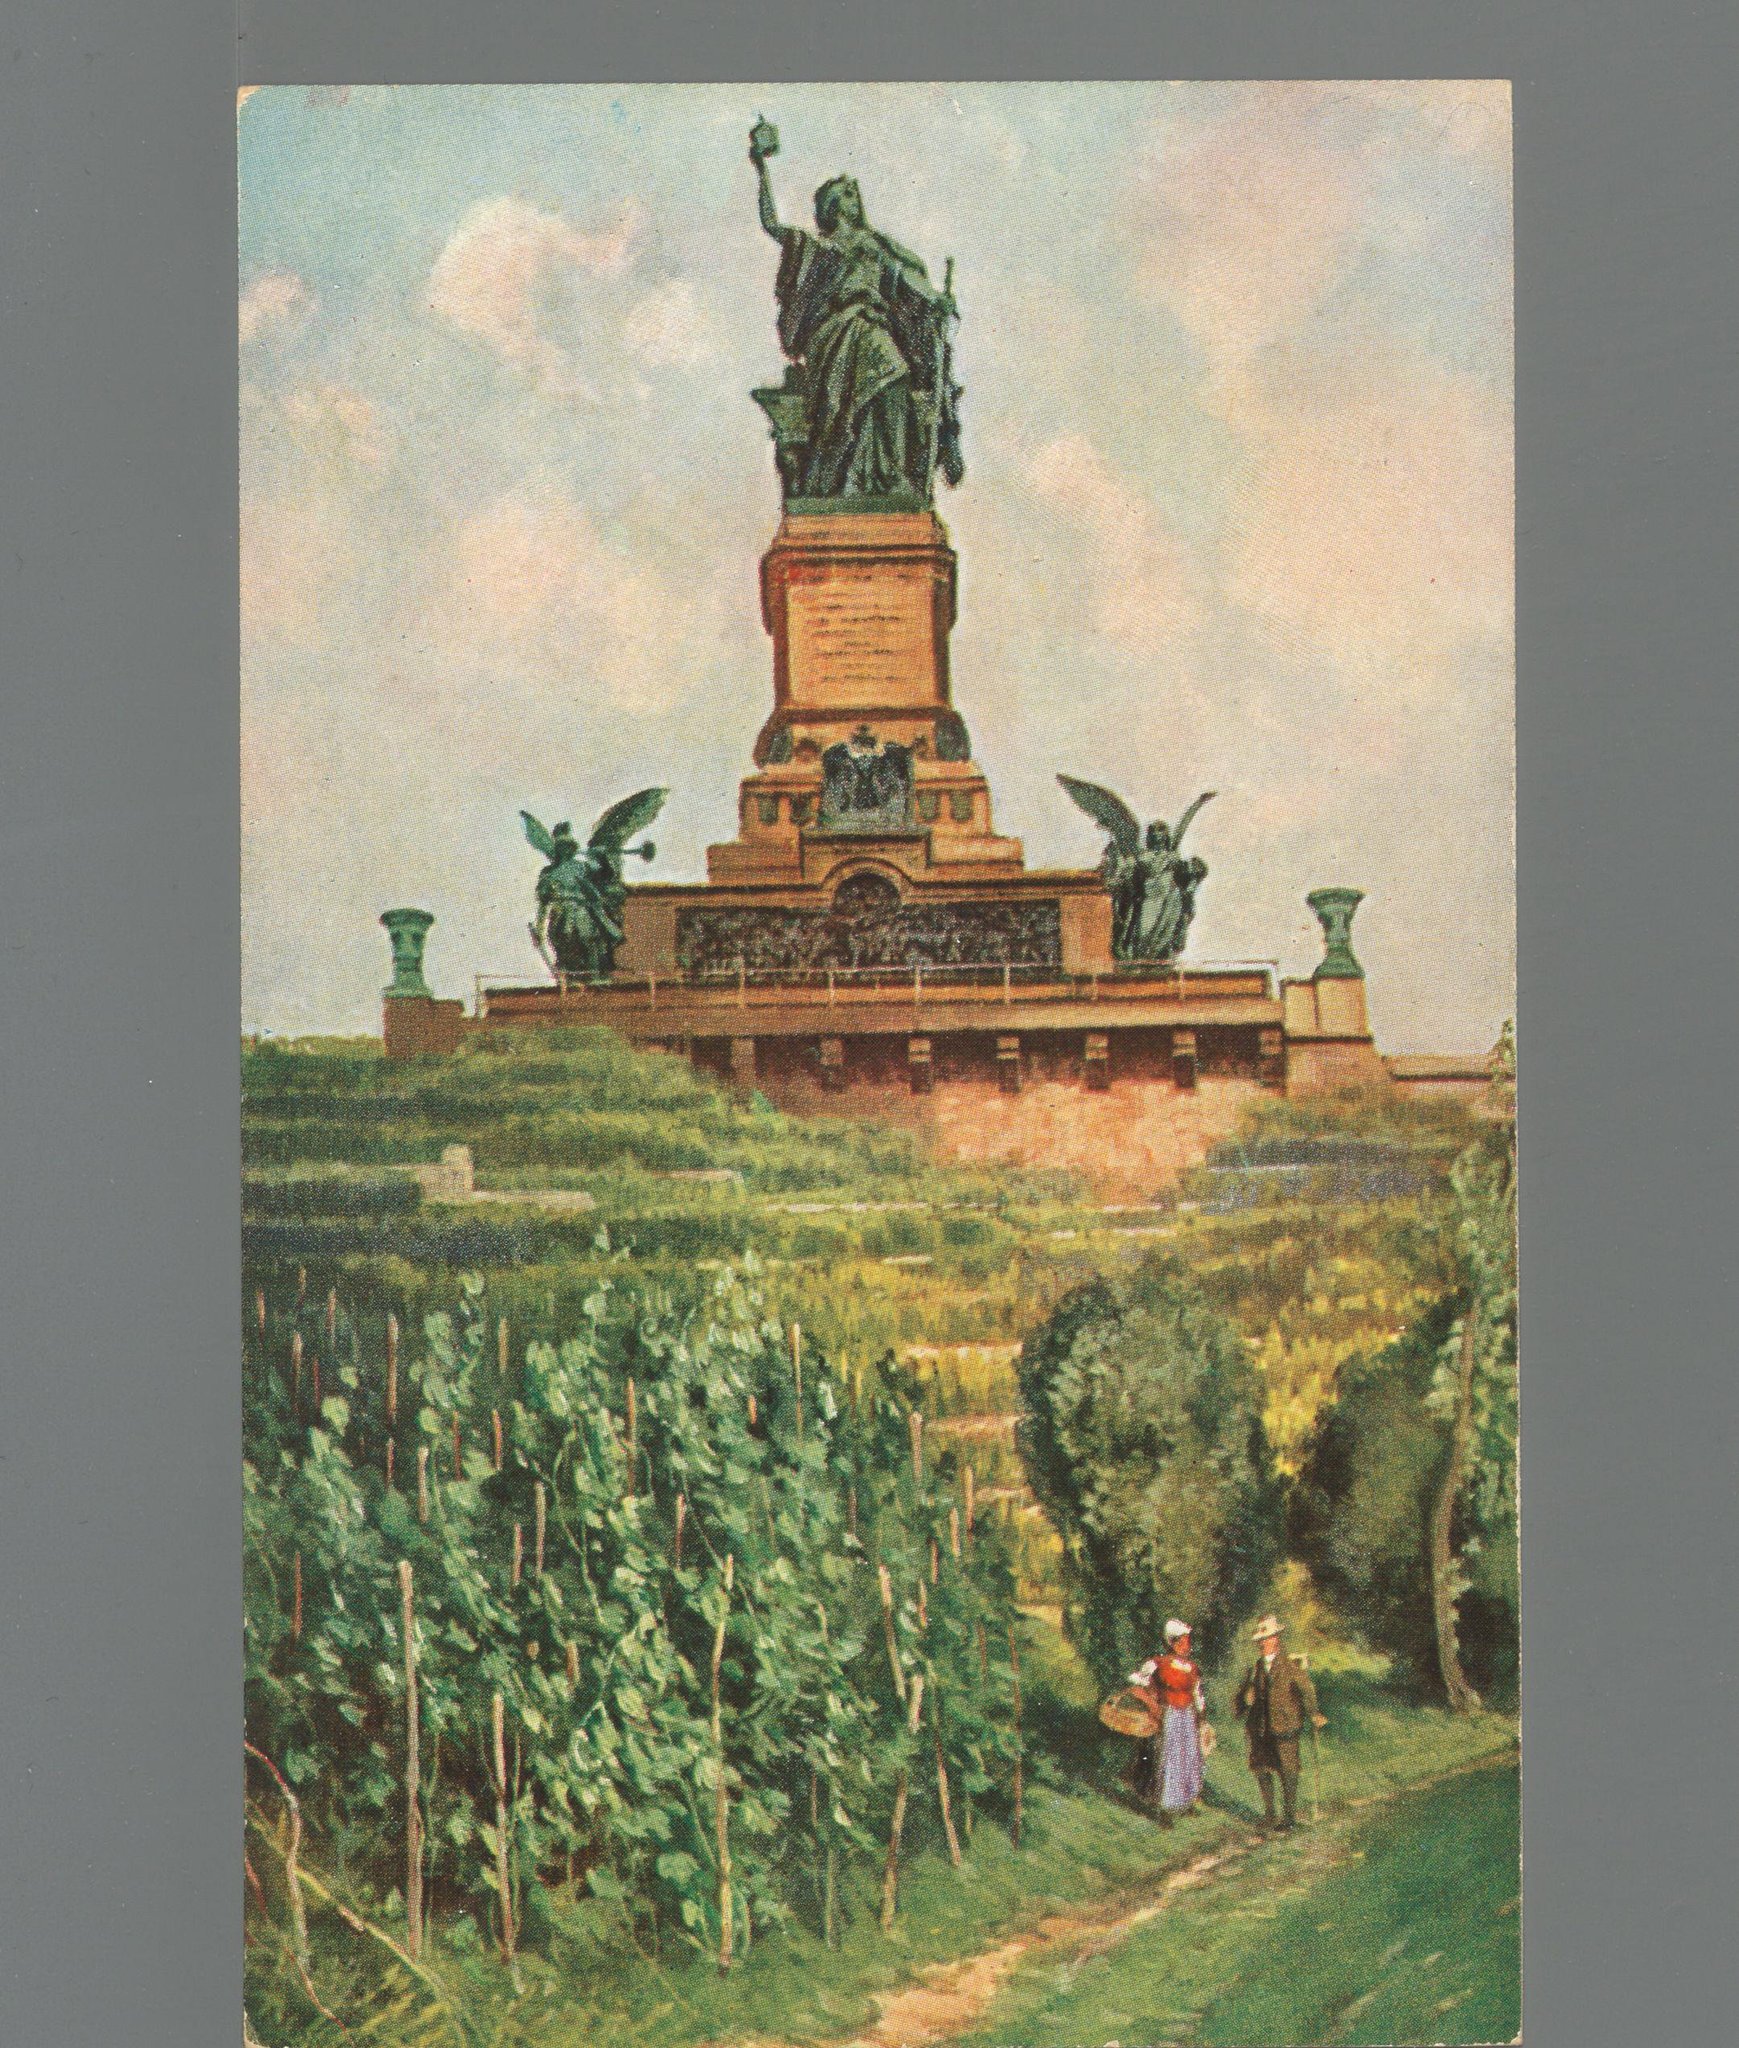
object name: photomechanical print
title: T.S.N. Serie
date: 1905-1930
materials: cardboard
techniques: color autotype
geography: nuremberg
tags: monument, statue